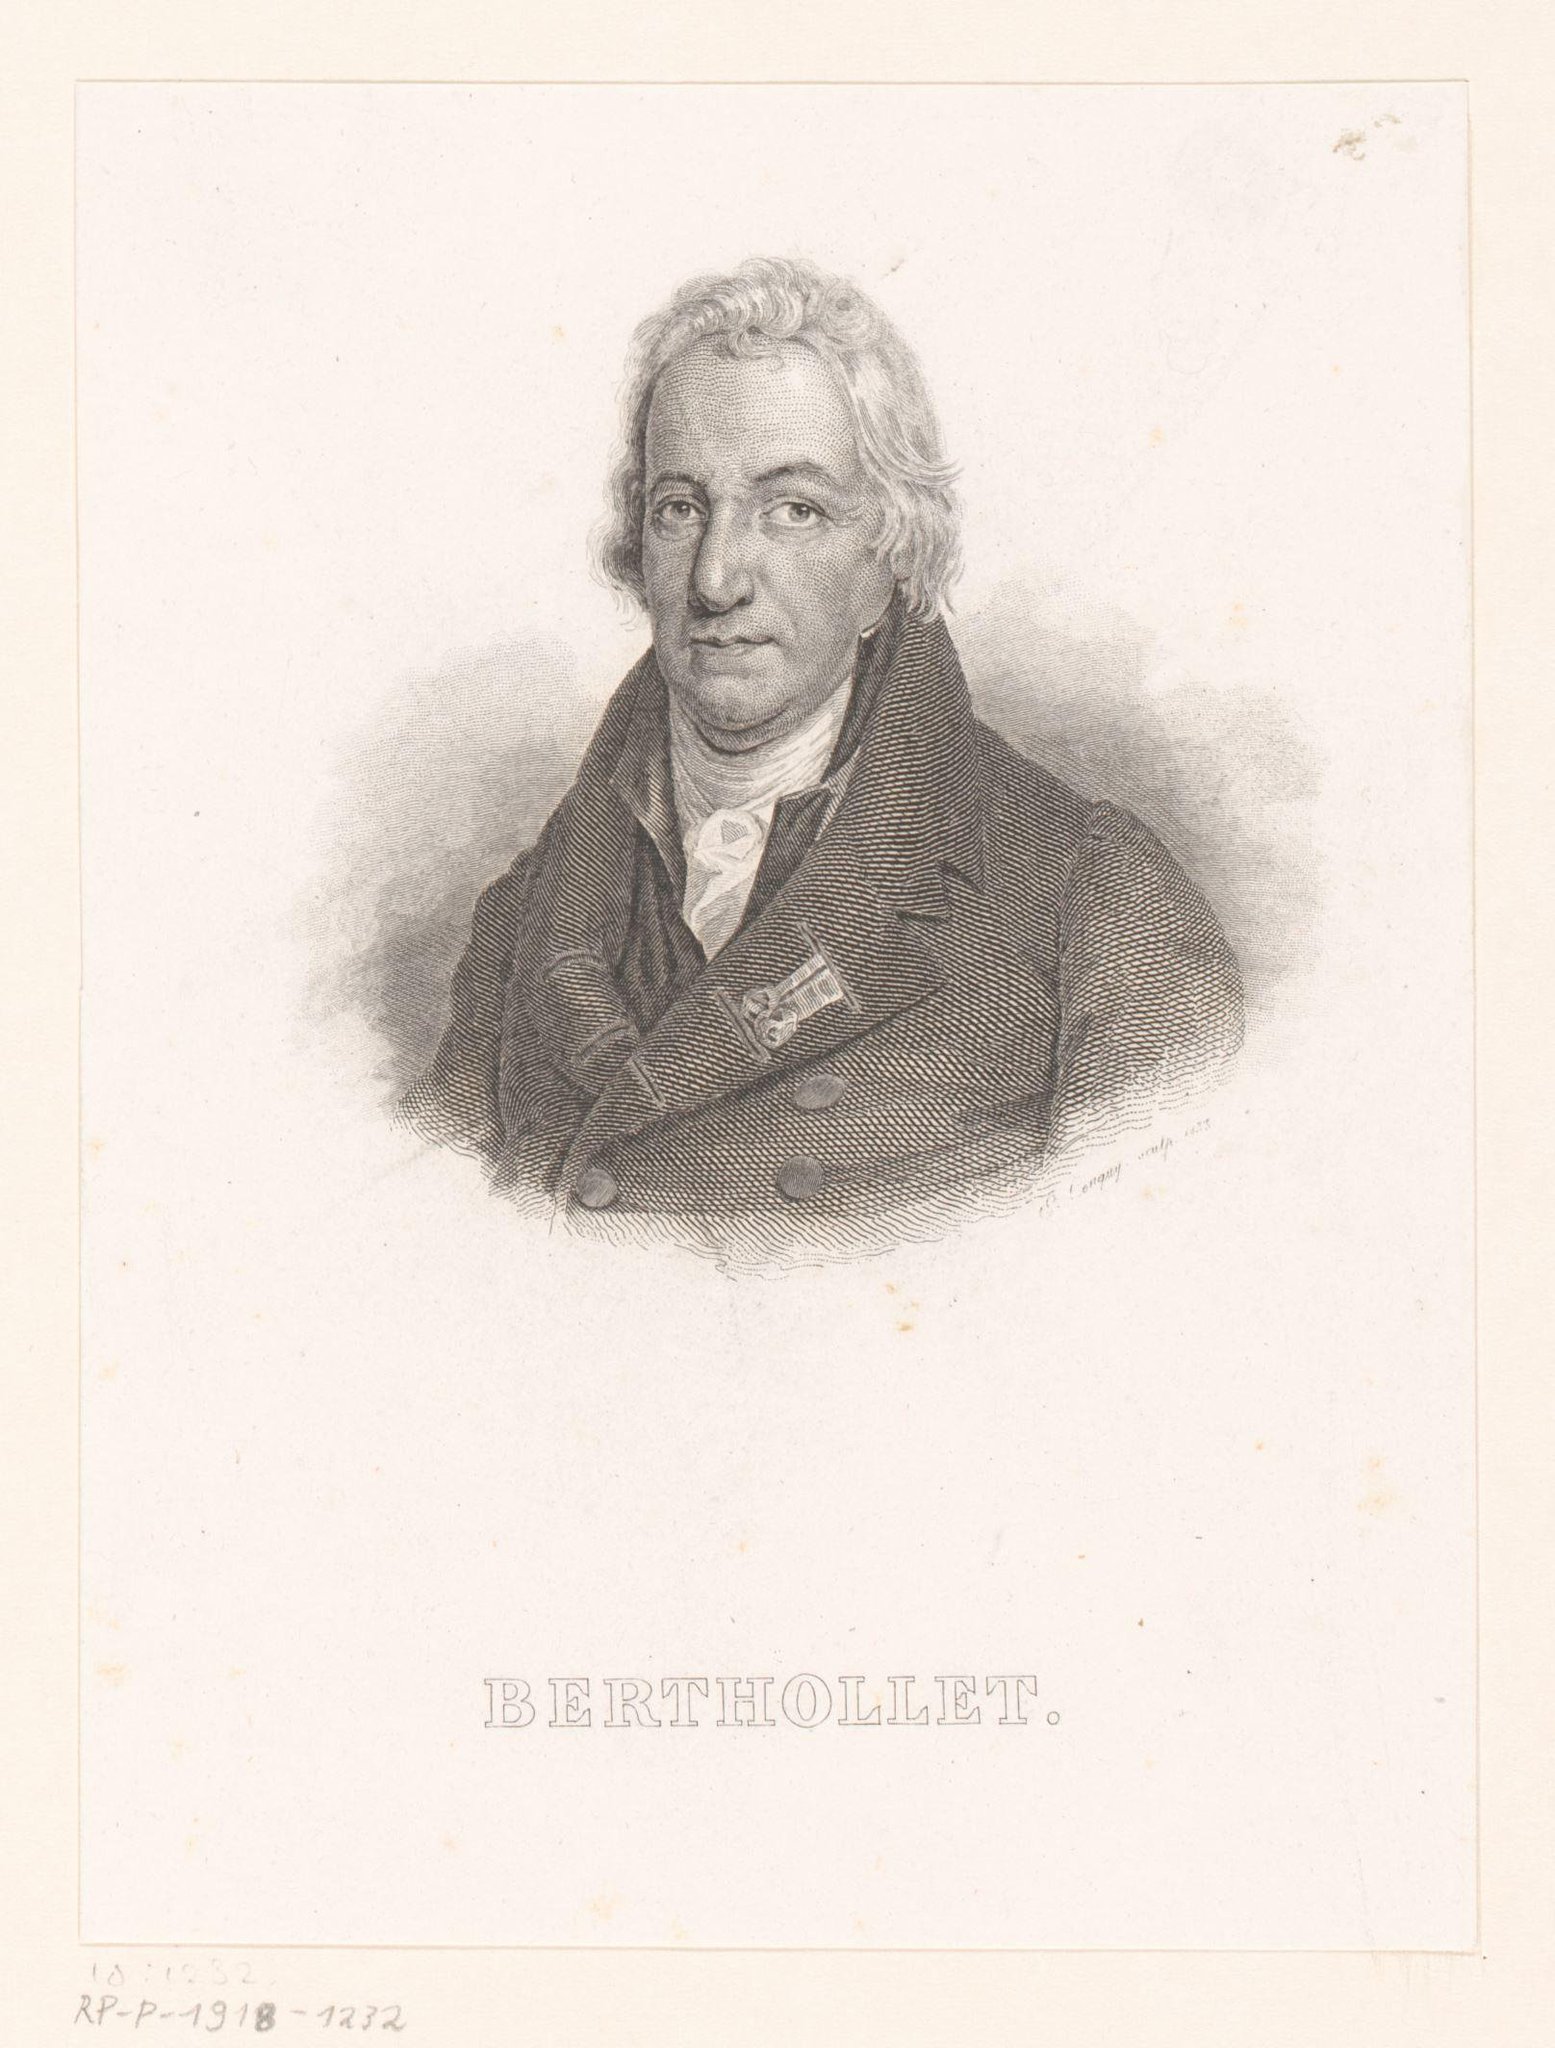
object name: print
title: Portret van Claude-Louis Berthollet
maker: ephraïm conquy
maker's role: print maker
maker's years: 1809-1843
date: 1833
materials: paper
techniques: engraving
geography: france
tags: historical persons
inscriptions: collector's mark: Lugt 2233